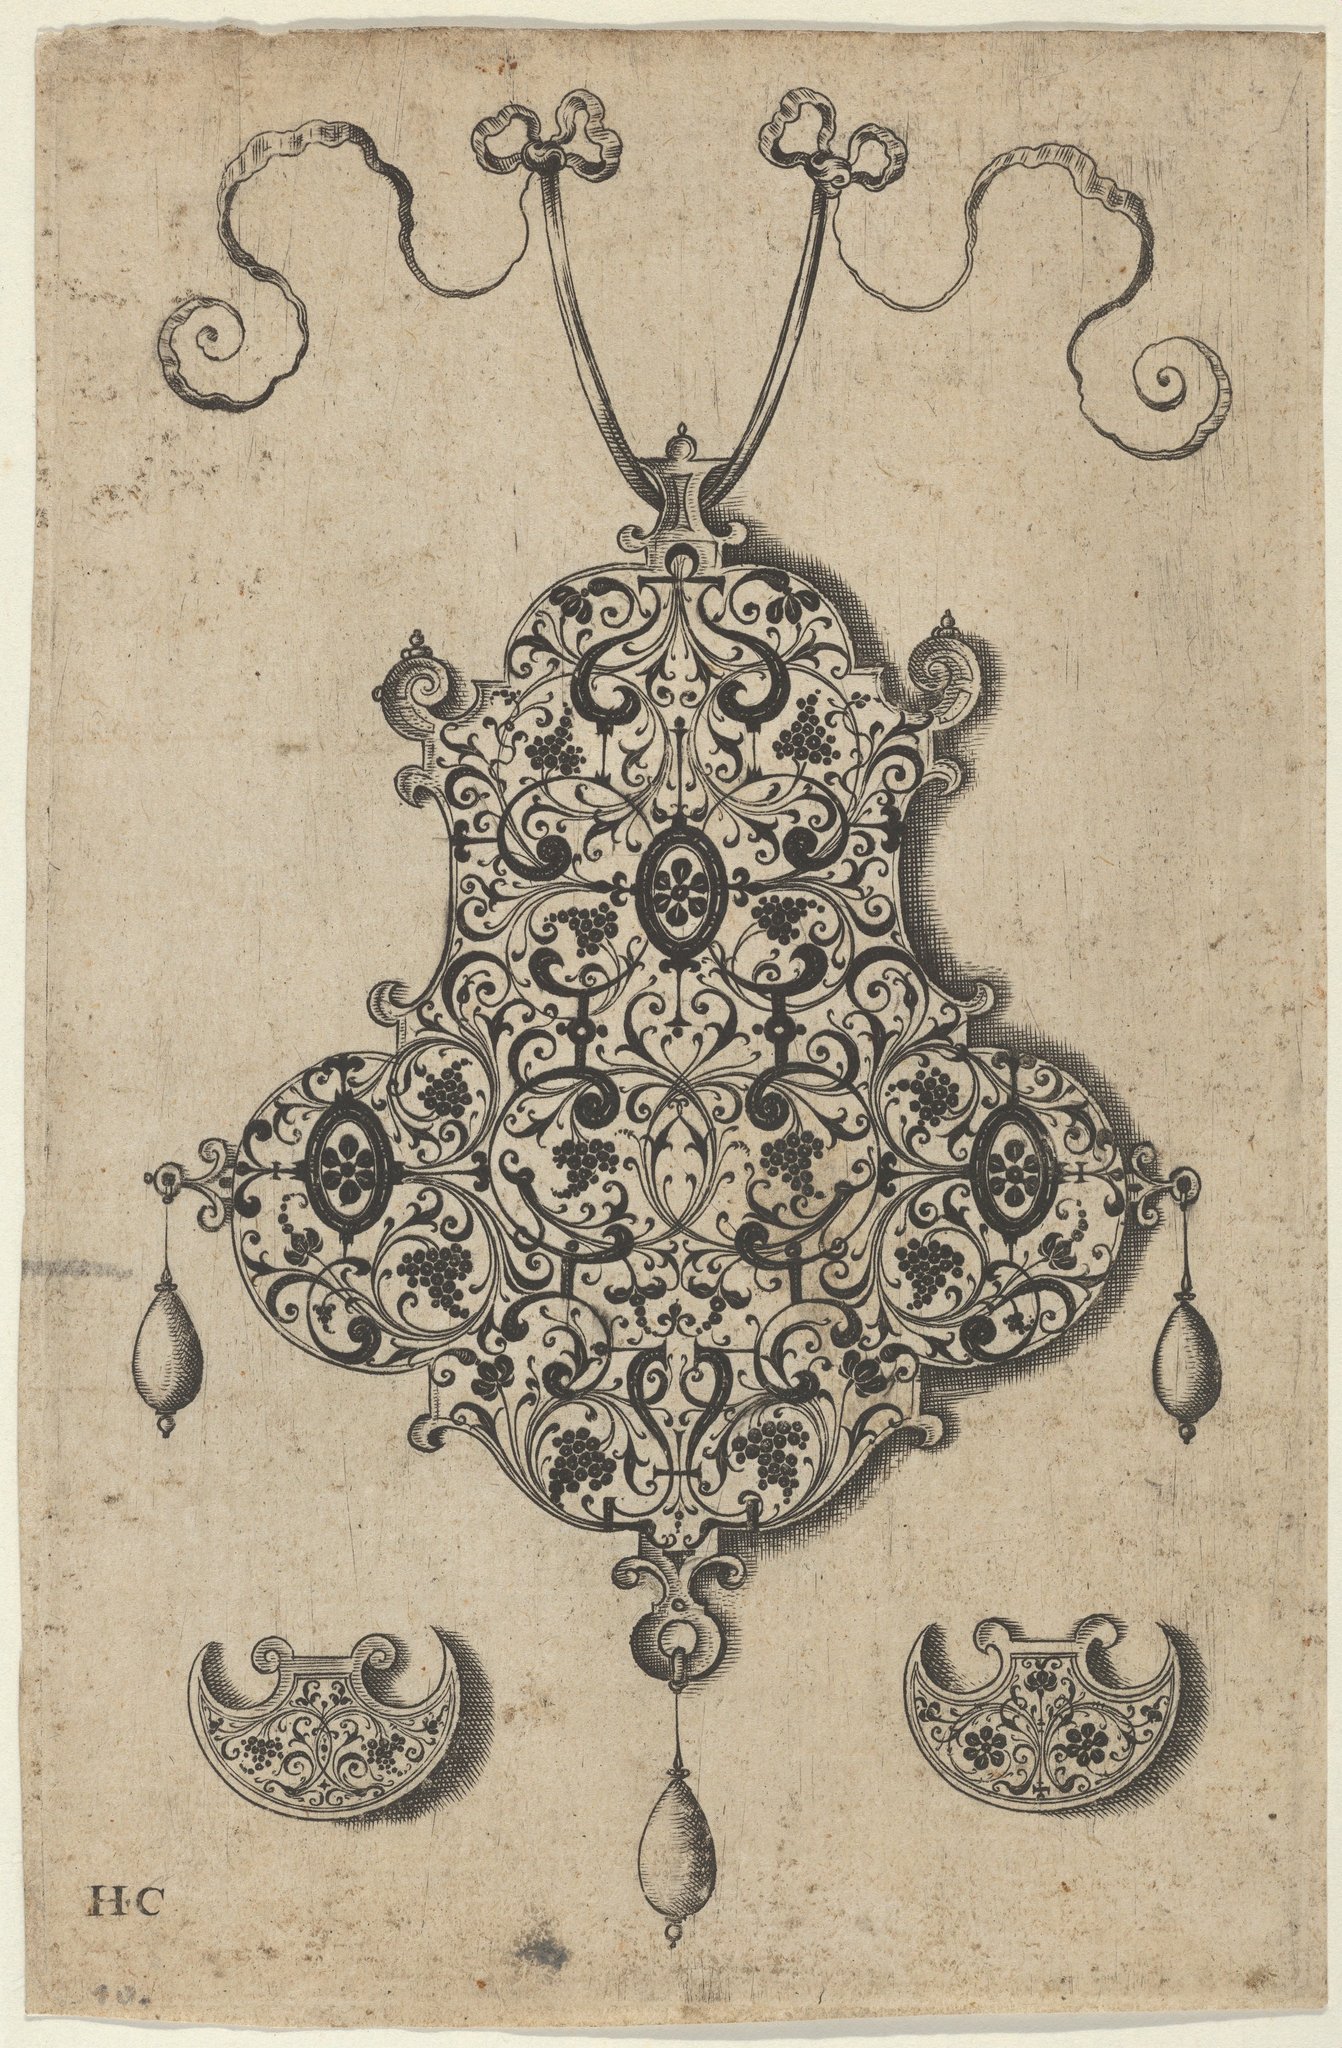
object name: print ornament architecture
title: Design for the Verso of a Pendant with Grapevines Above Axe-Shaped Ornaments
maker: jan collaert i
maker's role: artist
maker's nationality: netherlandish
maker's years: 1530-1581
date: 1573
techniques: embroidery, engraving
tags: pendants